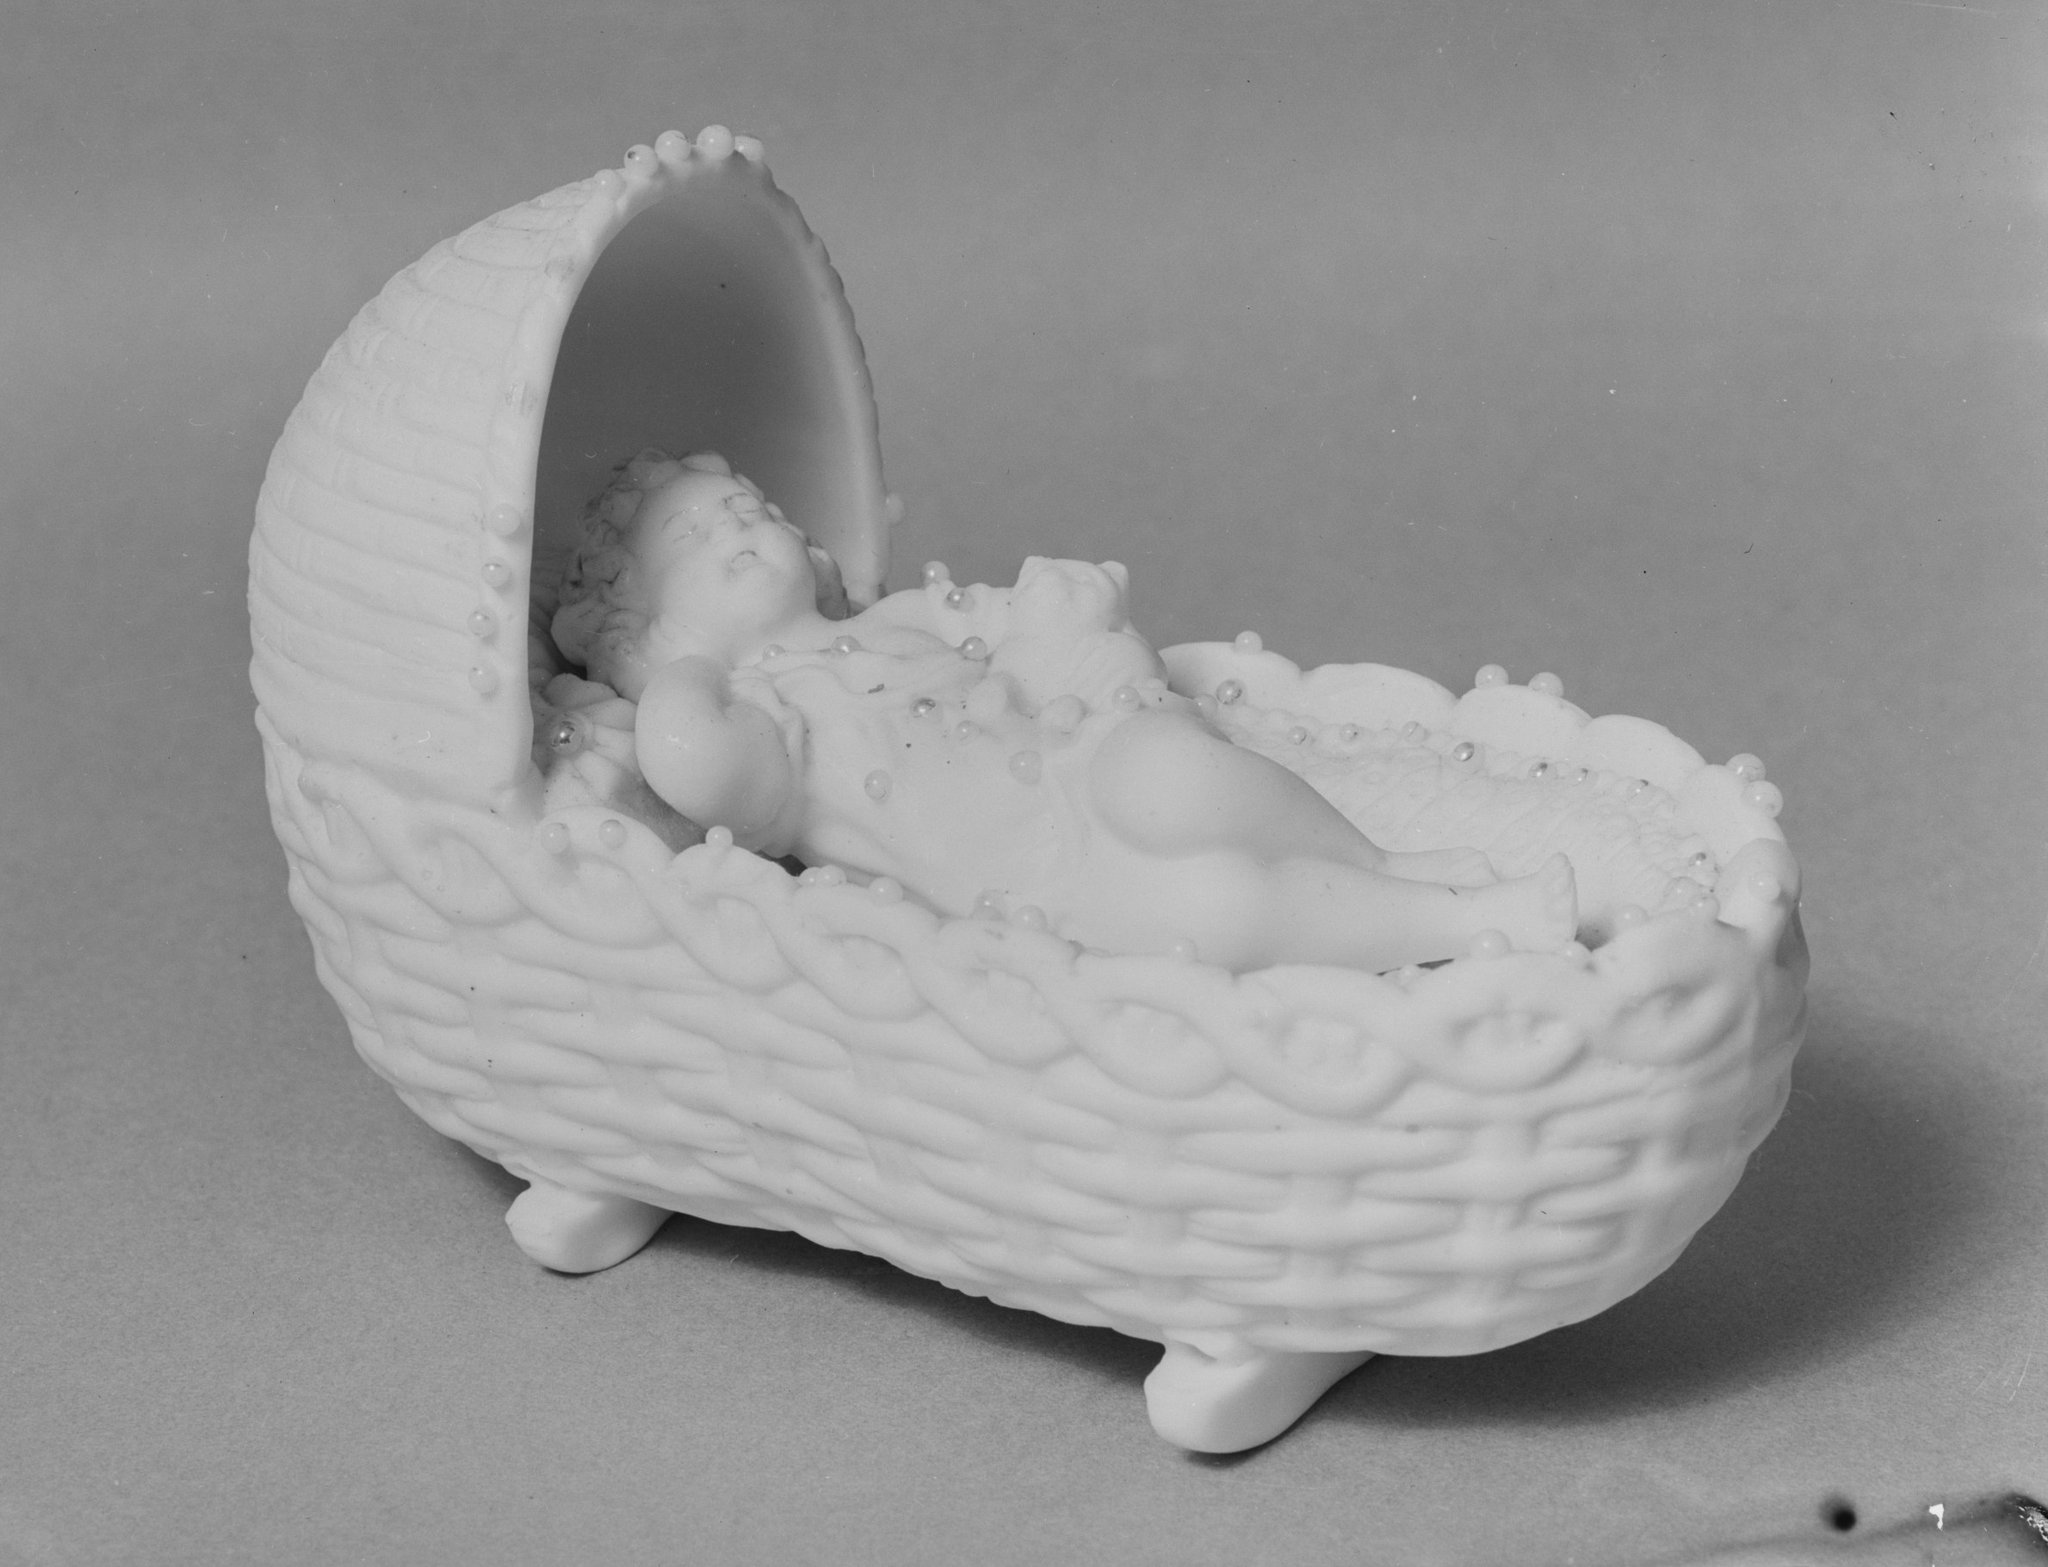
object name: figure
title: Figure of a Baby in a Cradle Holding a Kitten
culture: american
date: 1830-1870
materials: porcelain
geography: united states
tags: infants,cats,cradles